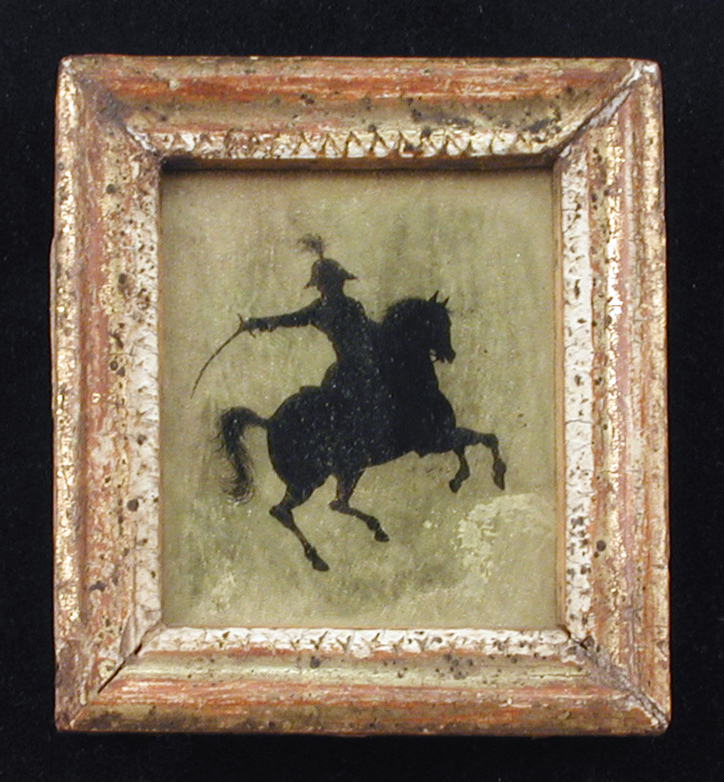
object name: panel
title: Napoleon on horseback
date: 1801-1900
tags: napoleon i,horses